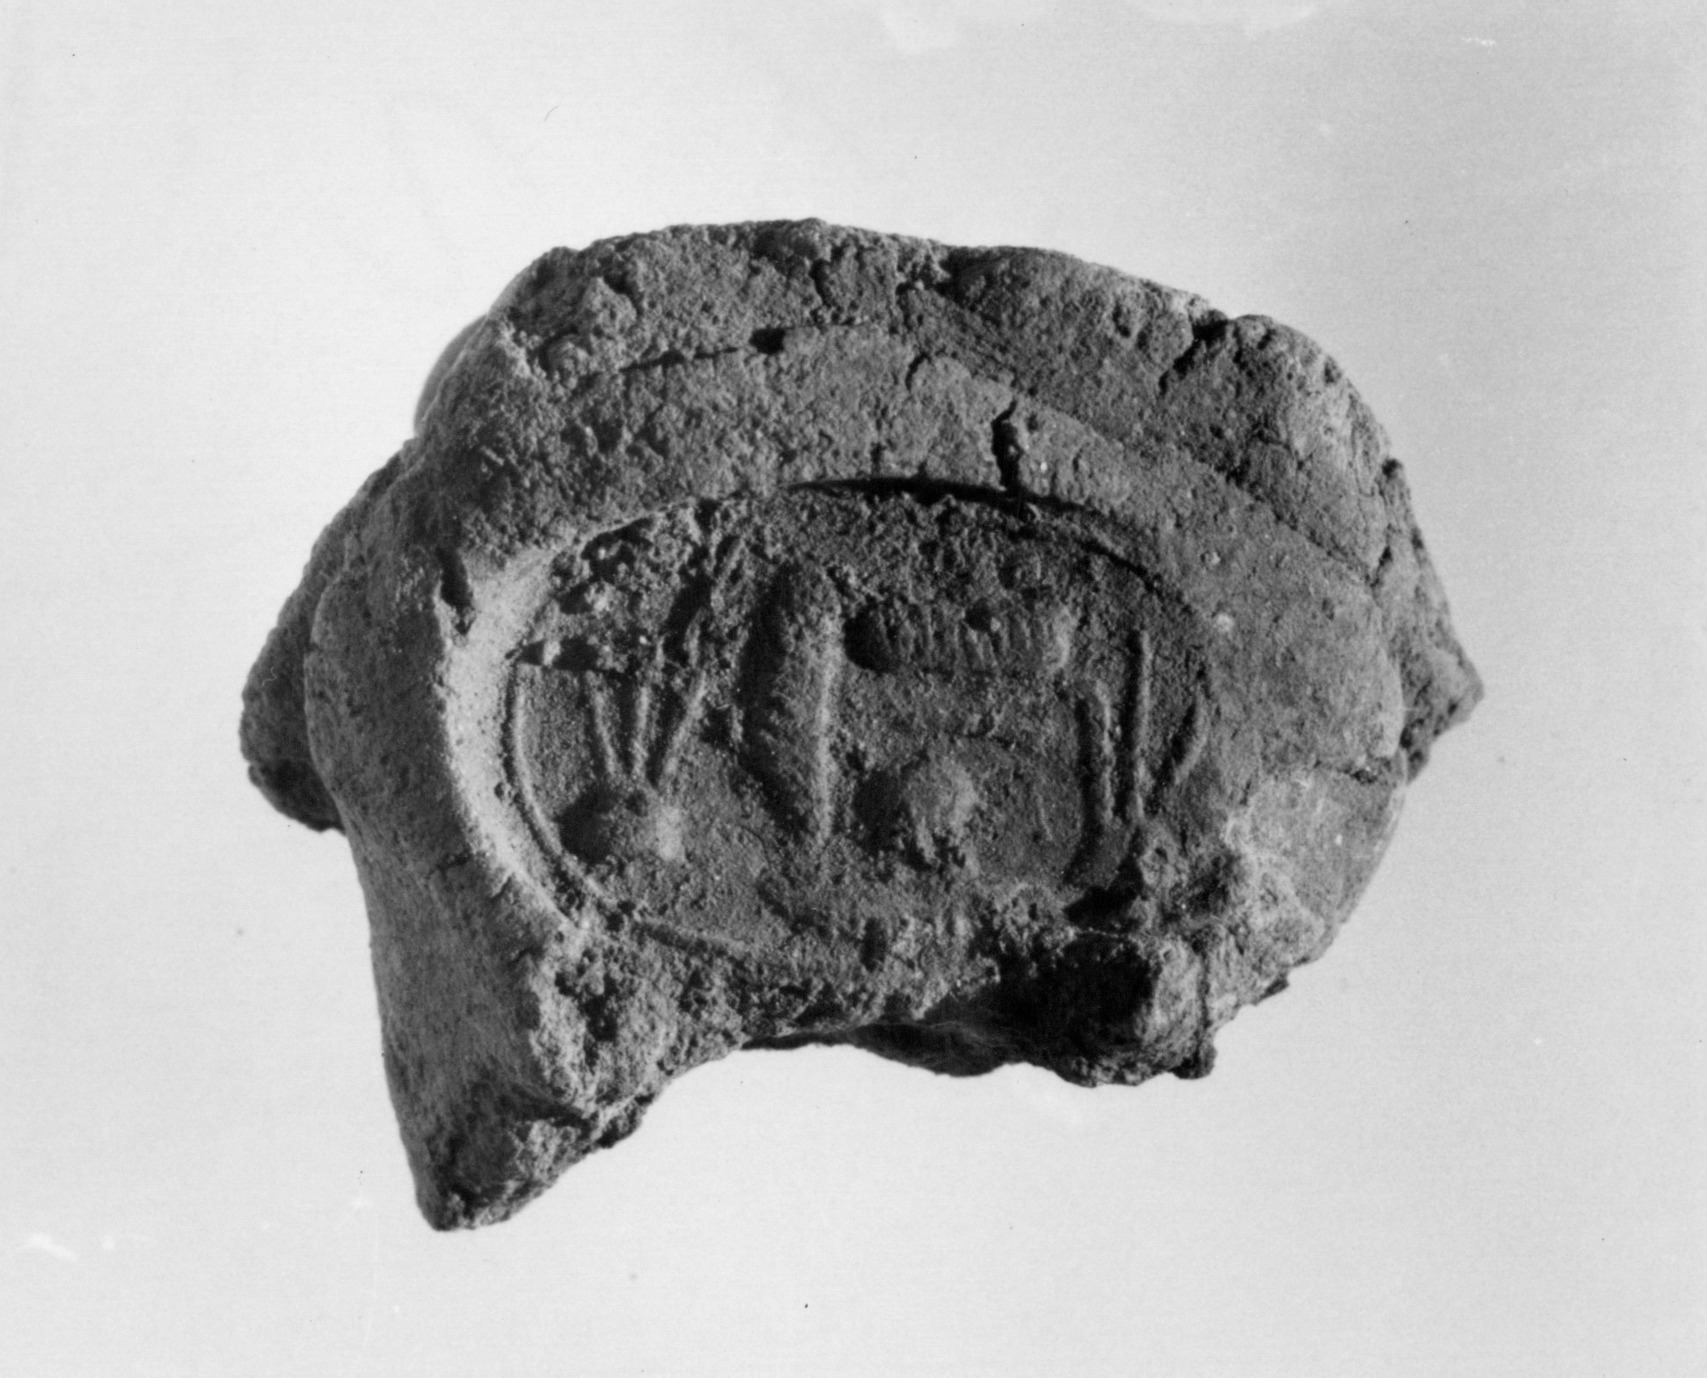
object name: sealing, amun re, upper egypt, lower egypt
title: Document Sealing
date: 1390-1352 BCE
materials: mud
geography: egypt